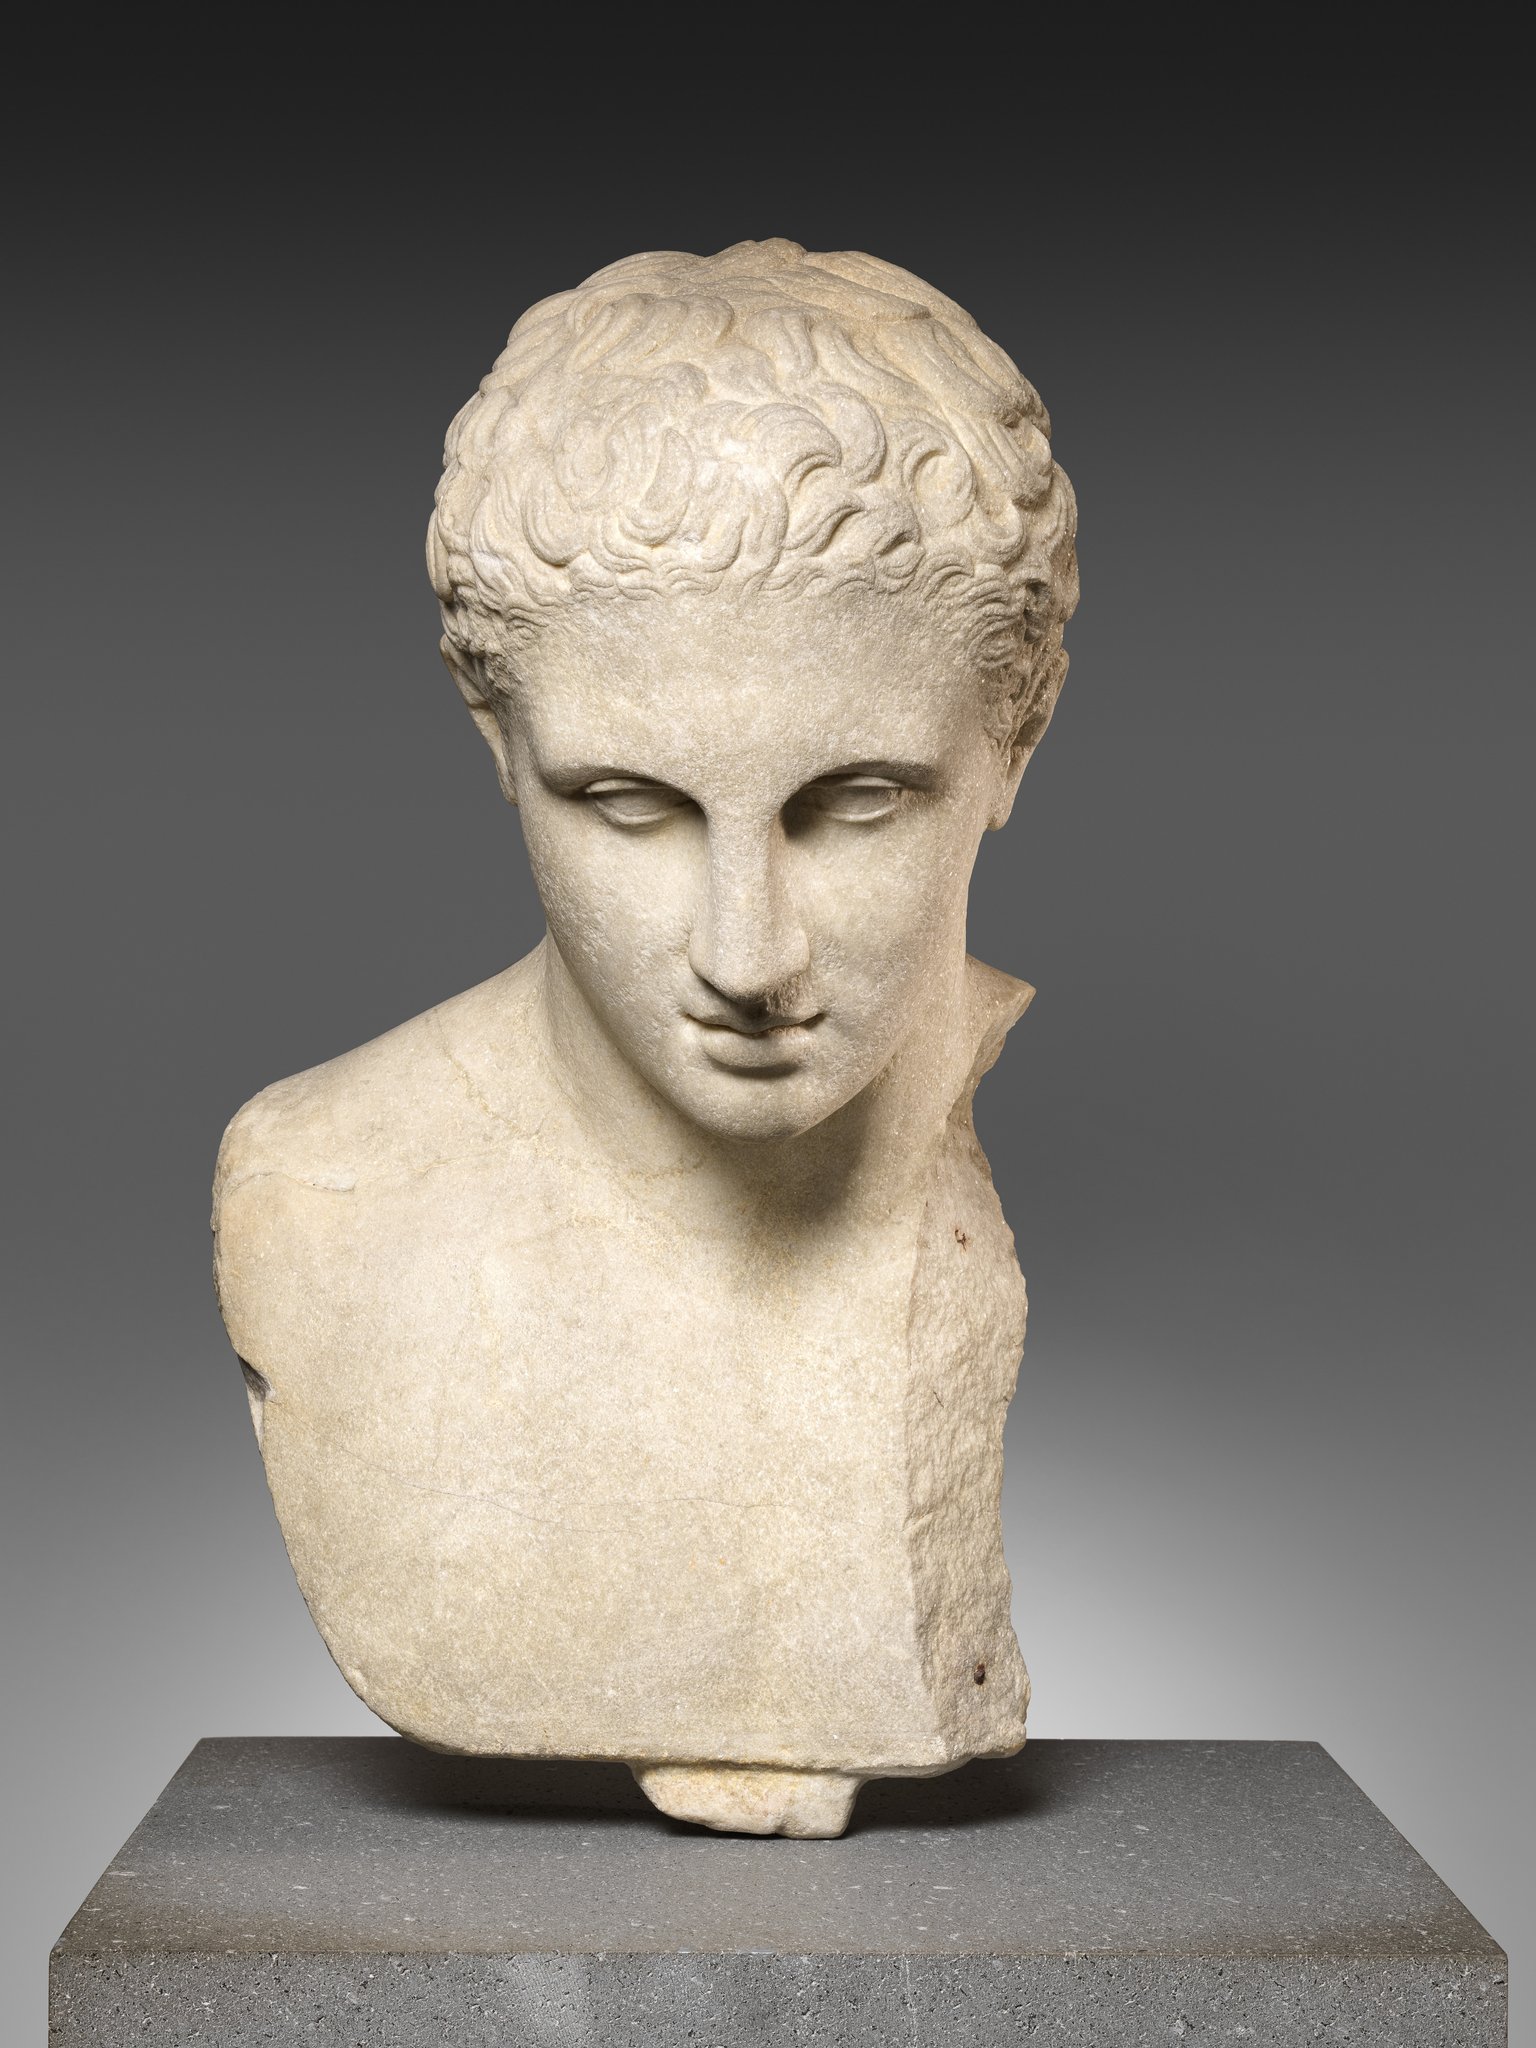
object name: head of an athlete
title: Marble bust of a youth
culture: roman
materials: marble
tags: men,portraits